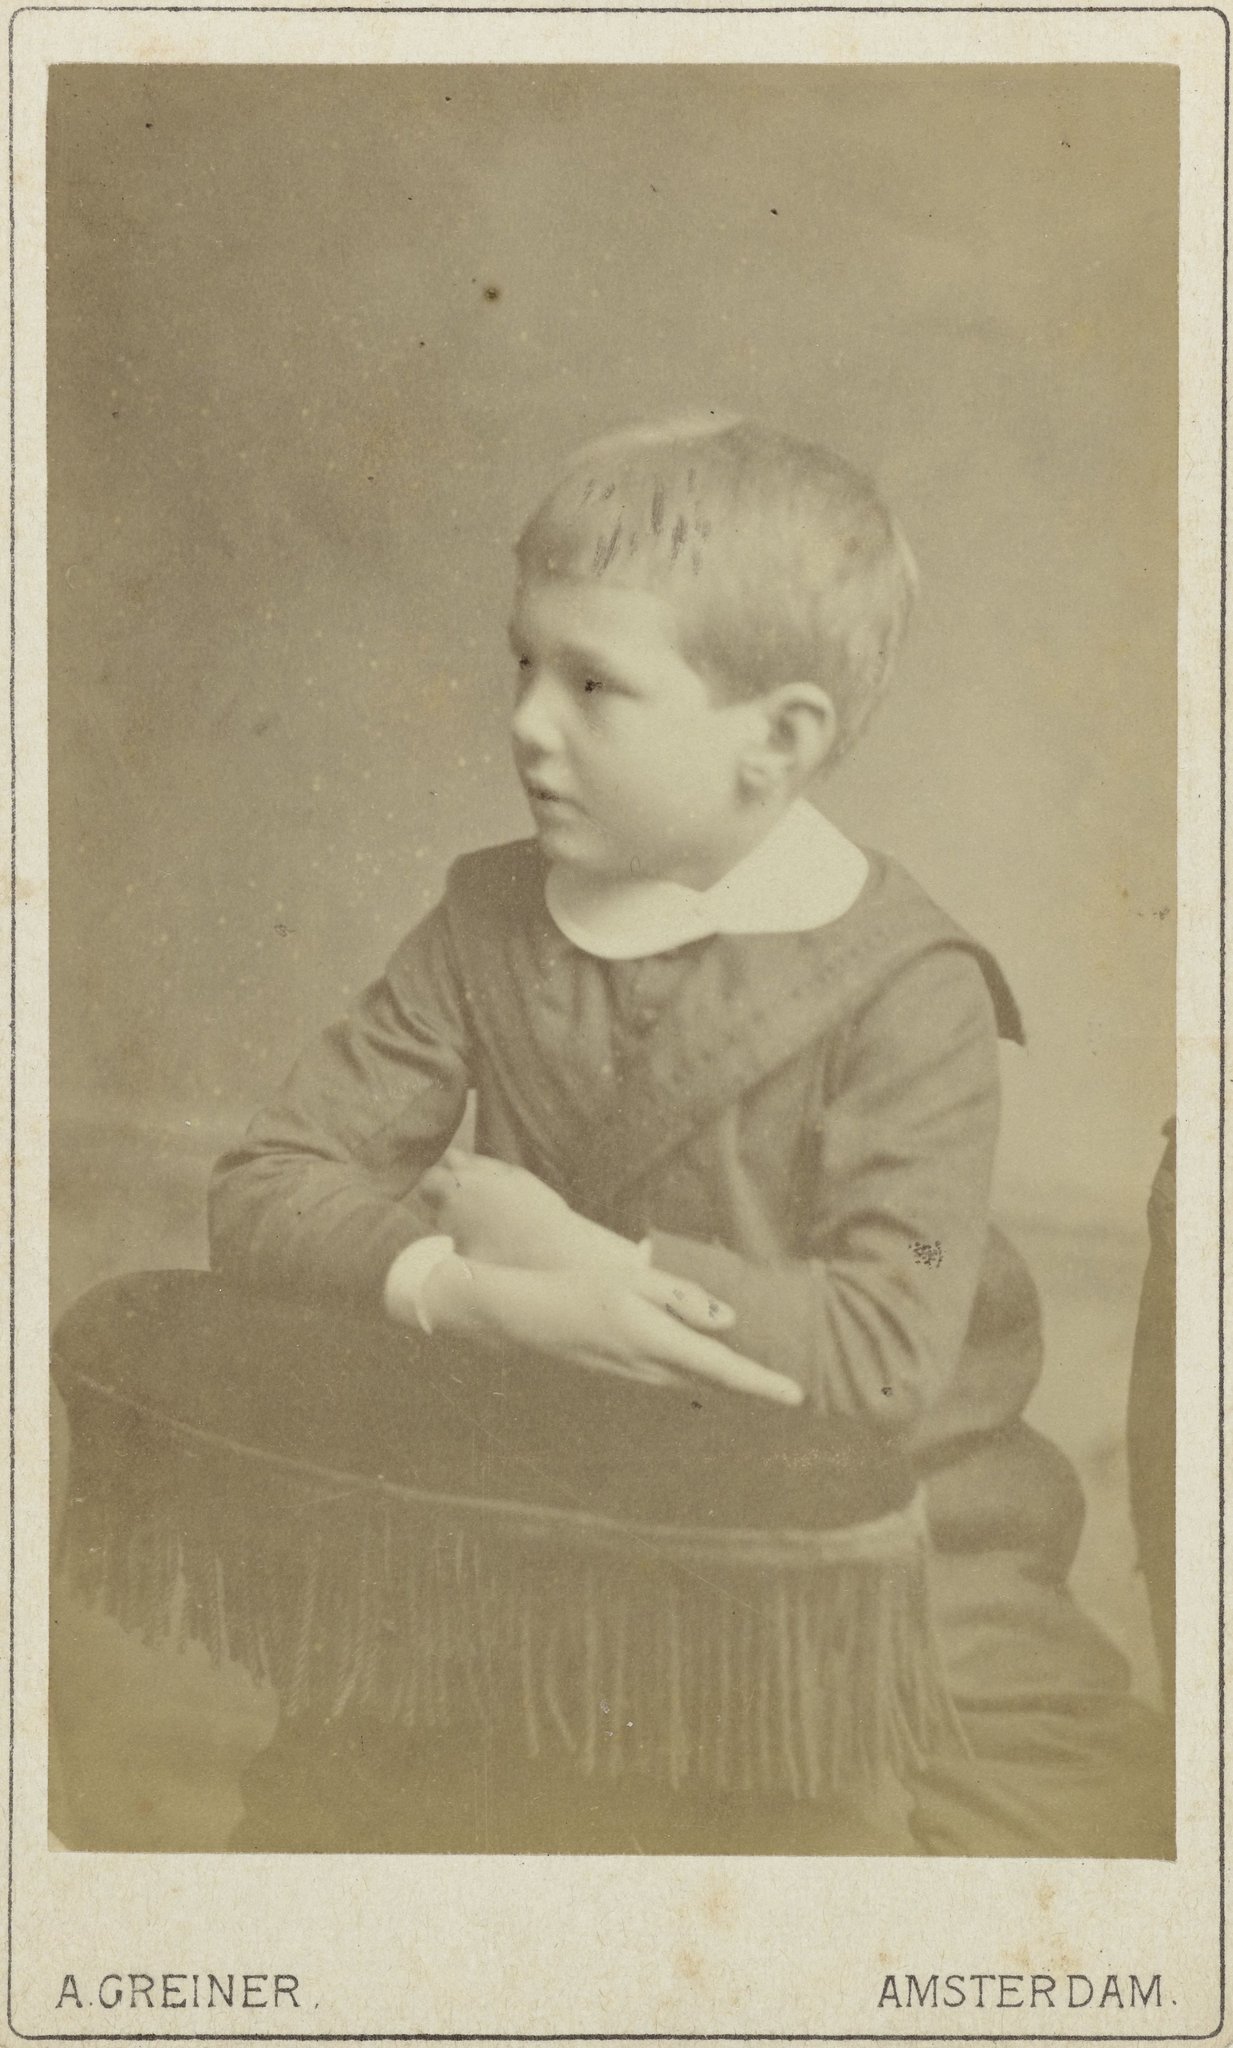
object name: carte de visite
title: Portret van Herman Marius Boelen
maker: albert greiner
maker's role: fotograaf, fotostudio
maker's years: 1833-1890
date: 1890-1892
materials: paper, photographic support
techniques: albumen print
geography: amsterdam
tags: anonymous historical person portrayed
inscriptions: name: ‘A. Greiner photograaf van H.H. M.M. den Koning en de koningin der Nederlanden. Nieuwendyk L89 Amsterdam’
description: De ogen van het jongetje zijn ingekleurd met zwarte pen